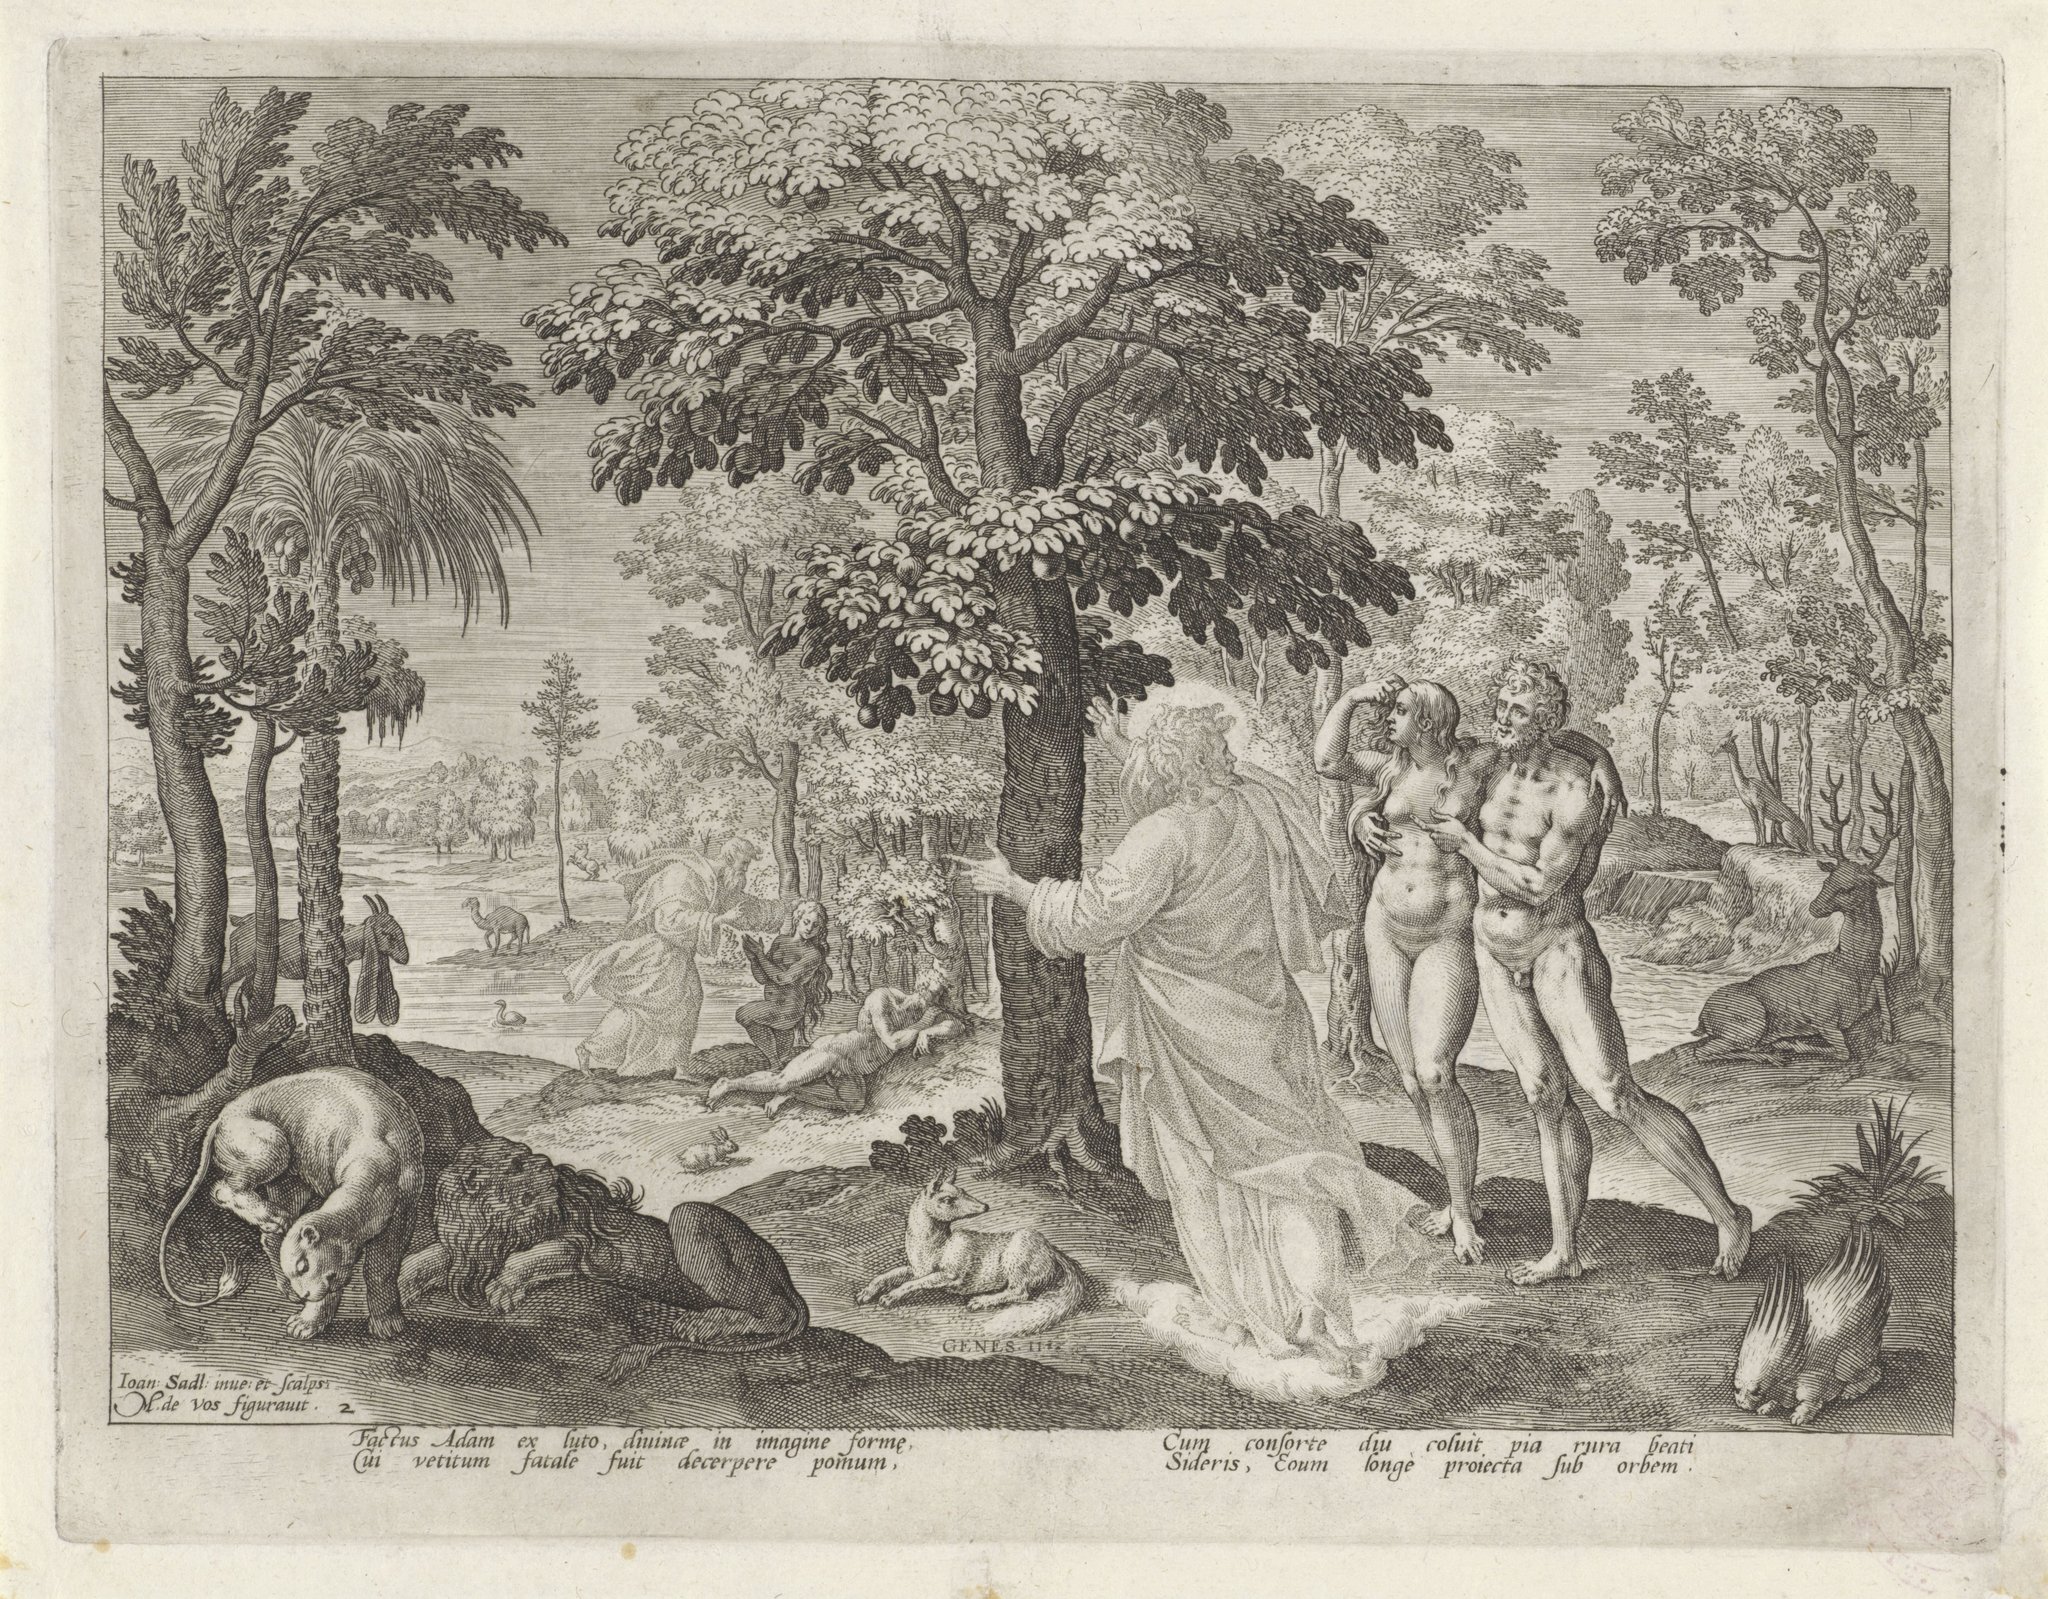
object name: print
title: Geschiedenis van de familie van Kaïn / Over goede en slechte werkzaamheden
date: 1583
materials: paper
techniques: engraving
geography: antwerp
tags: hoofed animals: deer, adam and eve in paradise (before the fall), god the father as bearded old man, usually with crown or tiara or sceptre and/or globe, creation of eve, beasts of prey, predatory animals: lion, beasts of prey, predatory animals: fox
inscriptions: collector's mark: Lugt 240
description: Adam en Eva wandelen met God in het paradijs. Rondom hen verschillende dieren. Op de achtergrond de schepping van Eva. De prent heeft een Latijns onderschrift.